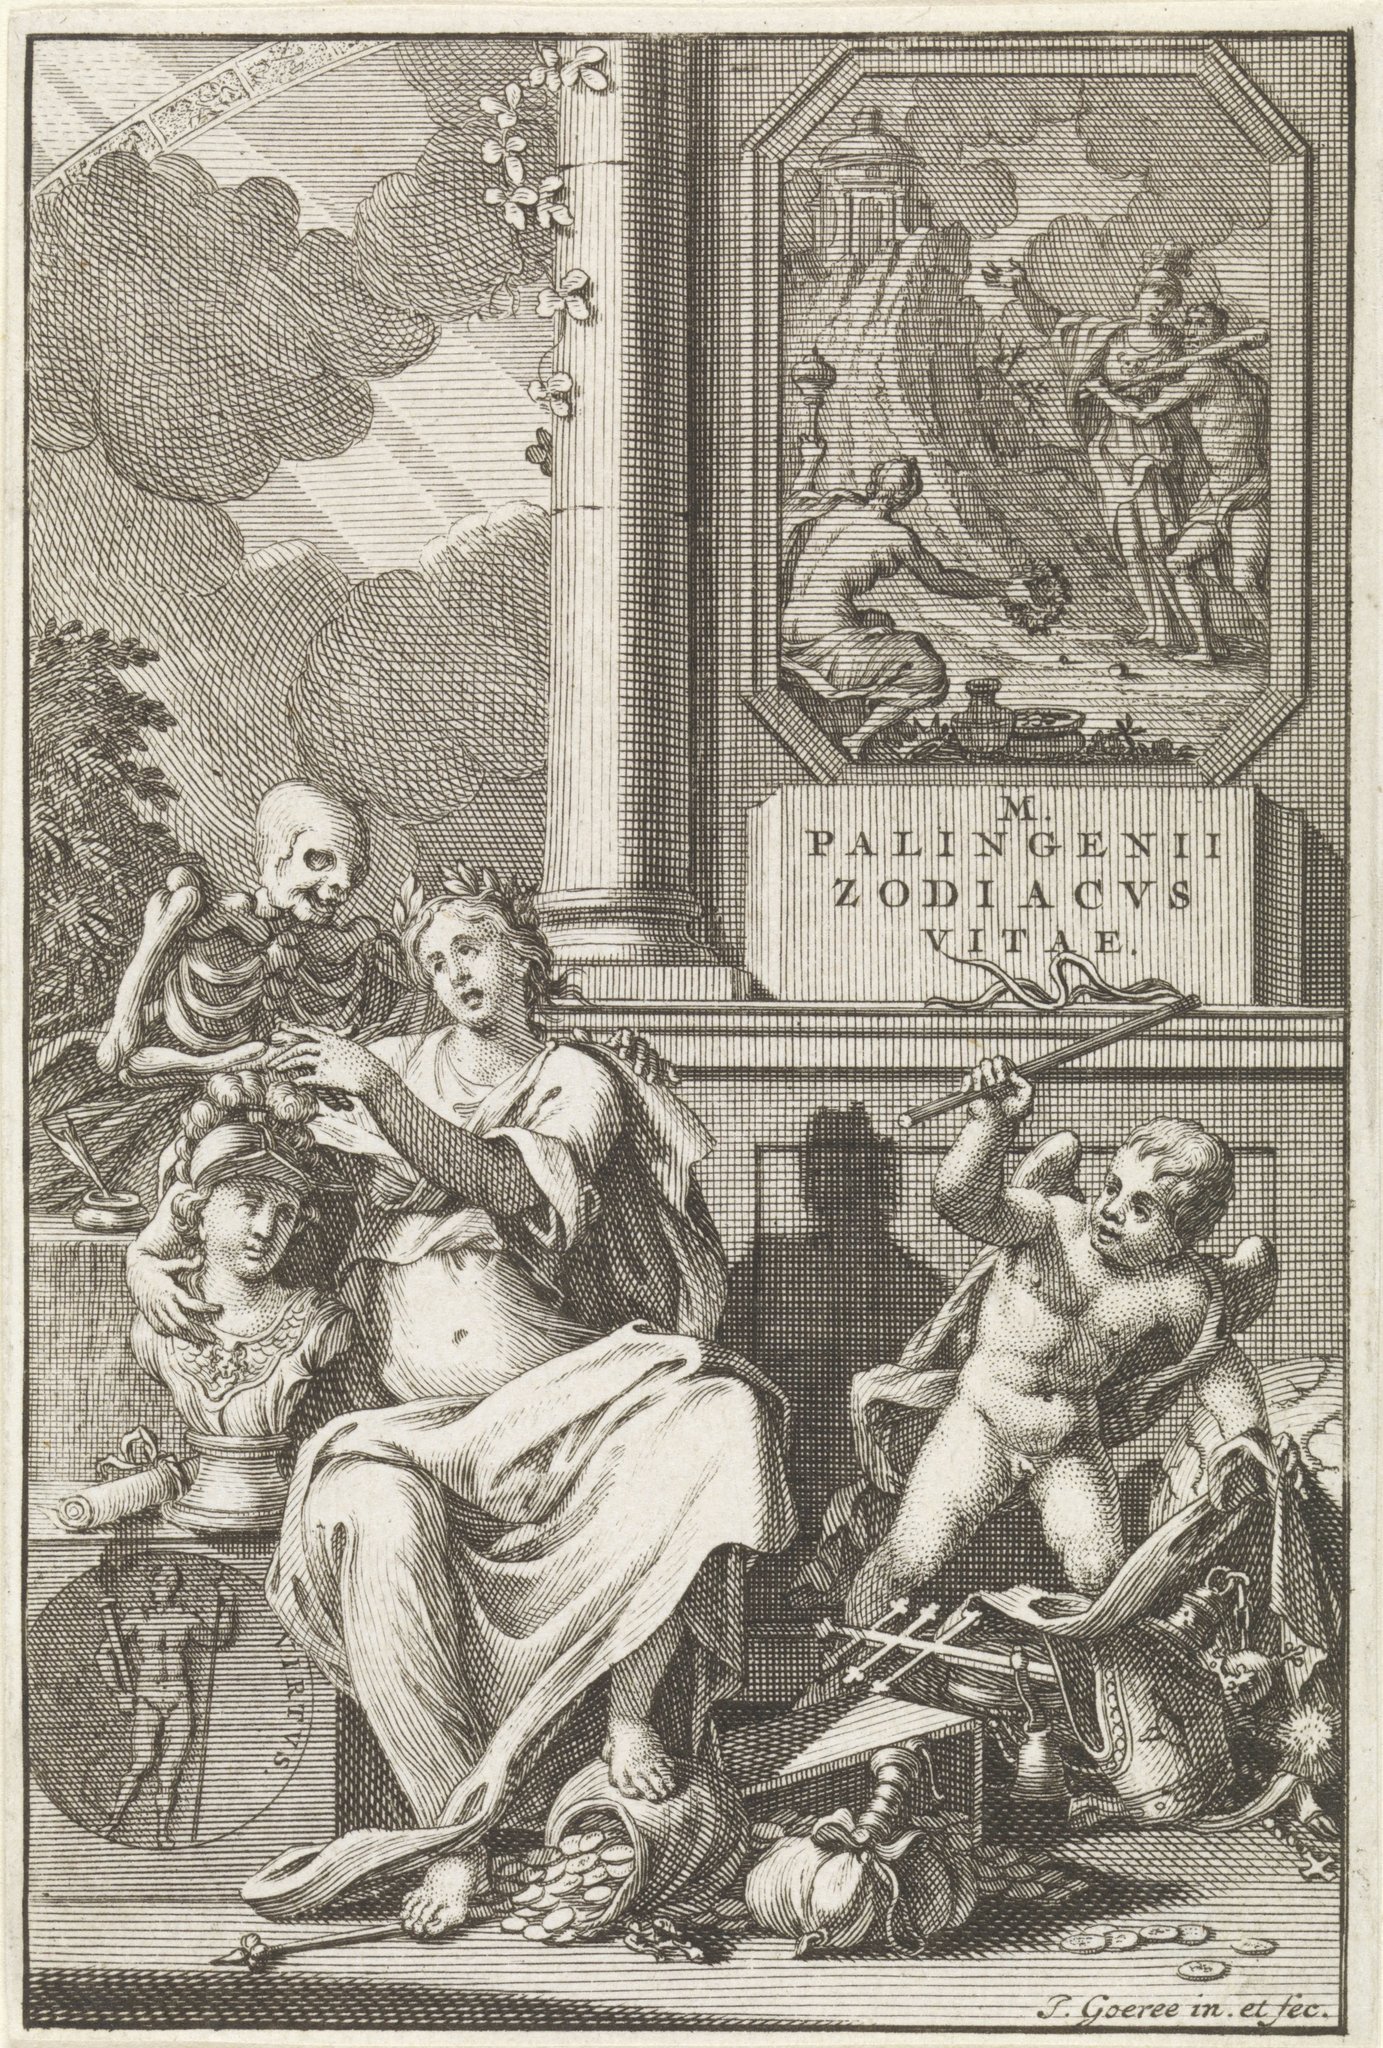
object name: print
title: Zodiacvs Vitae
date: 1722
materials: paper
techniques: engraving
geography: amsterdam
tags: (story of) minerva (pallas, athena), death as skeleton, hercules at the cross-roads, 'herkules am scheidewege': the choice of hercules, zodiac; the twelve zodiacal signs together, cupids: 'amores', 'amoretti', 'putti', money, the church vs. the world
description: Een vrouw met lauwerkroon zit op een bank naast de standbeeldbuste van Minerva. Zij houdt de hand vast van de Dood. Aan haar voeten liggen wereldse rijkdommen. Rechts onthult een putto met een zweep symbolen van de kerk, verscholen onder een deken. Achter de putto een muur met de titel van het boekwerk en een wandschildering van Hercules op de tweesprong. Op de achtergrond in de lucht een deel van de zodiac.